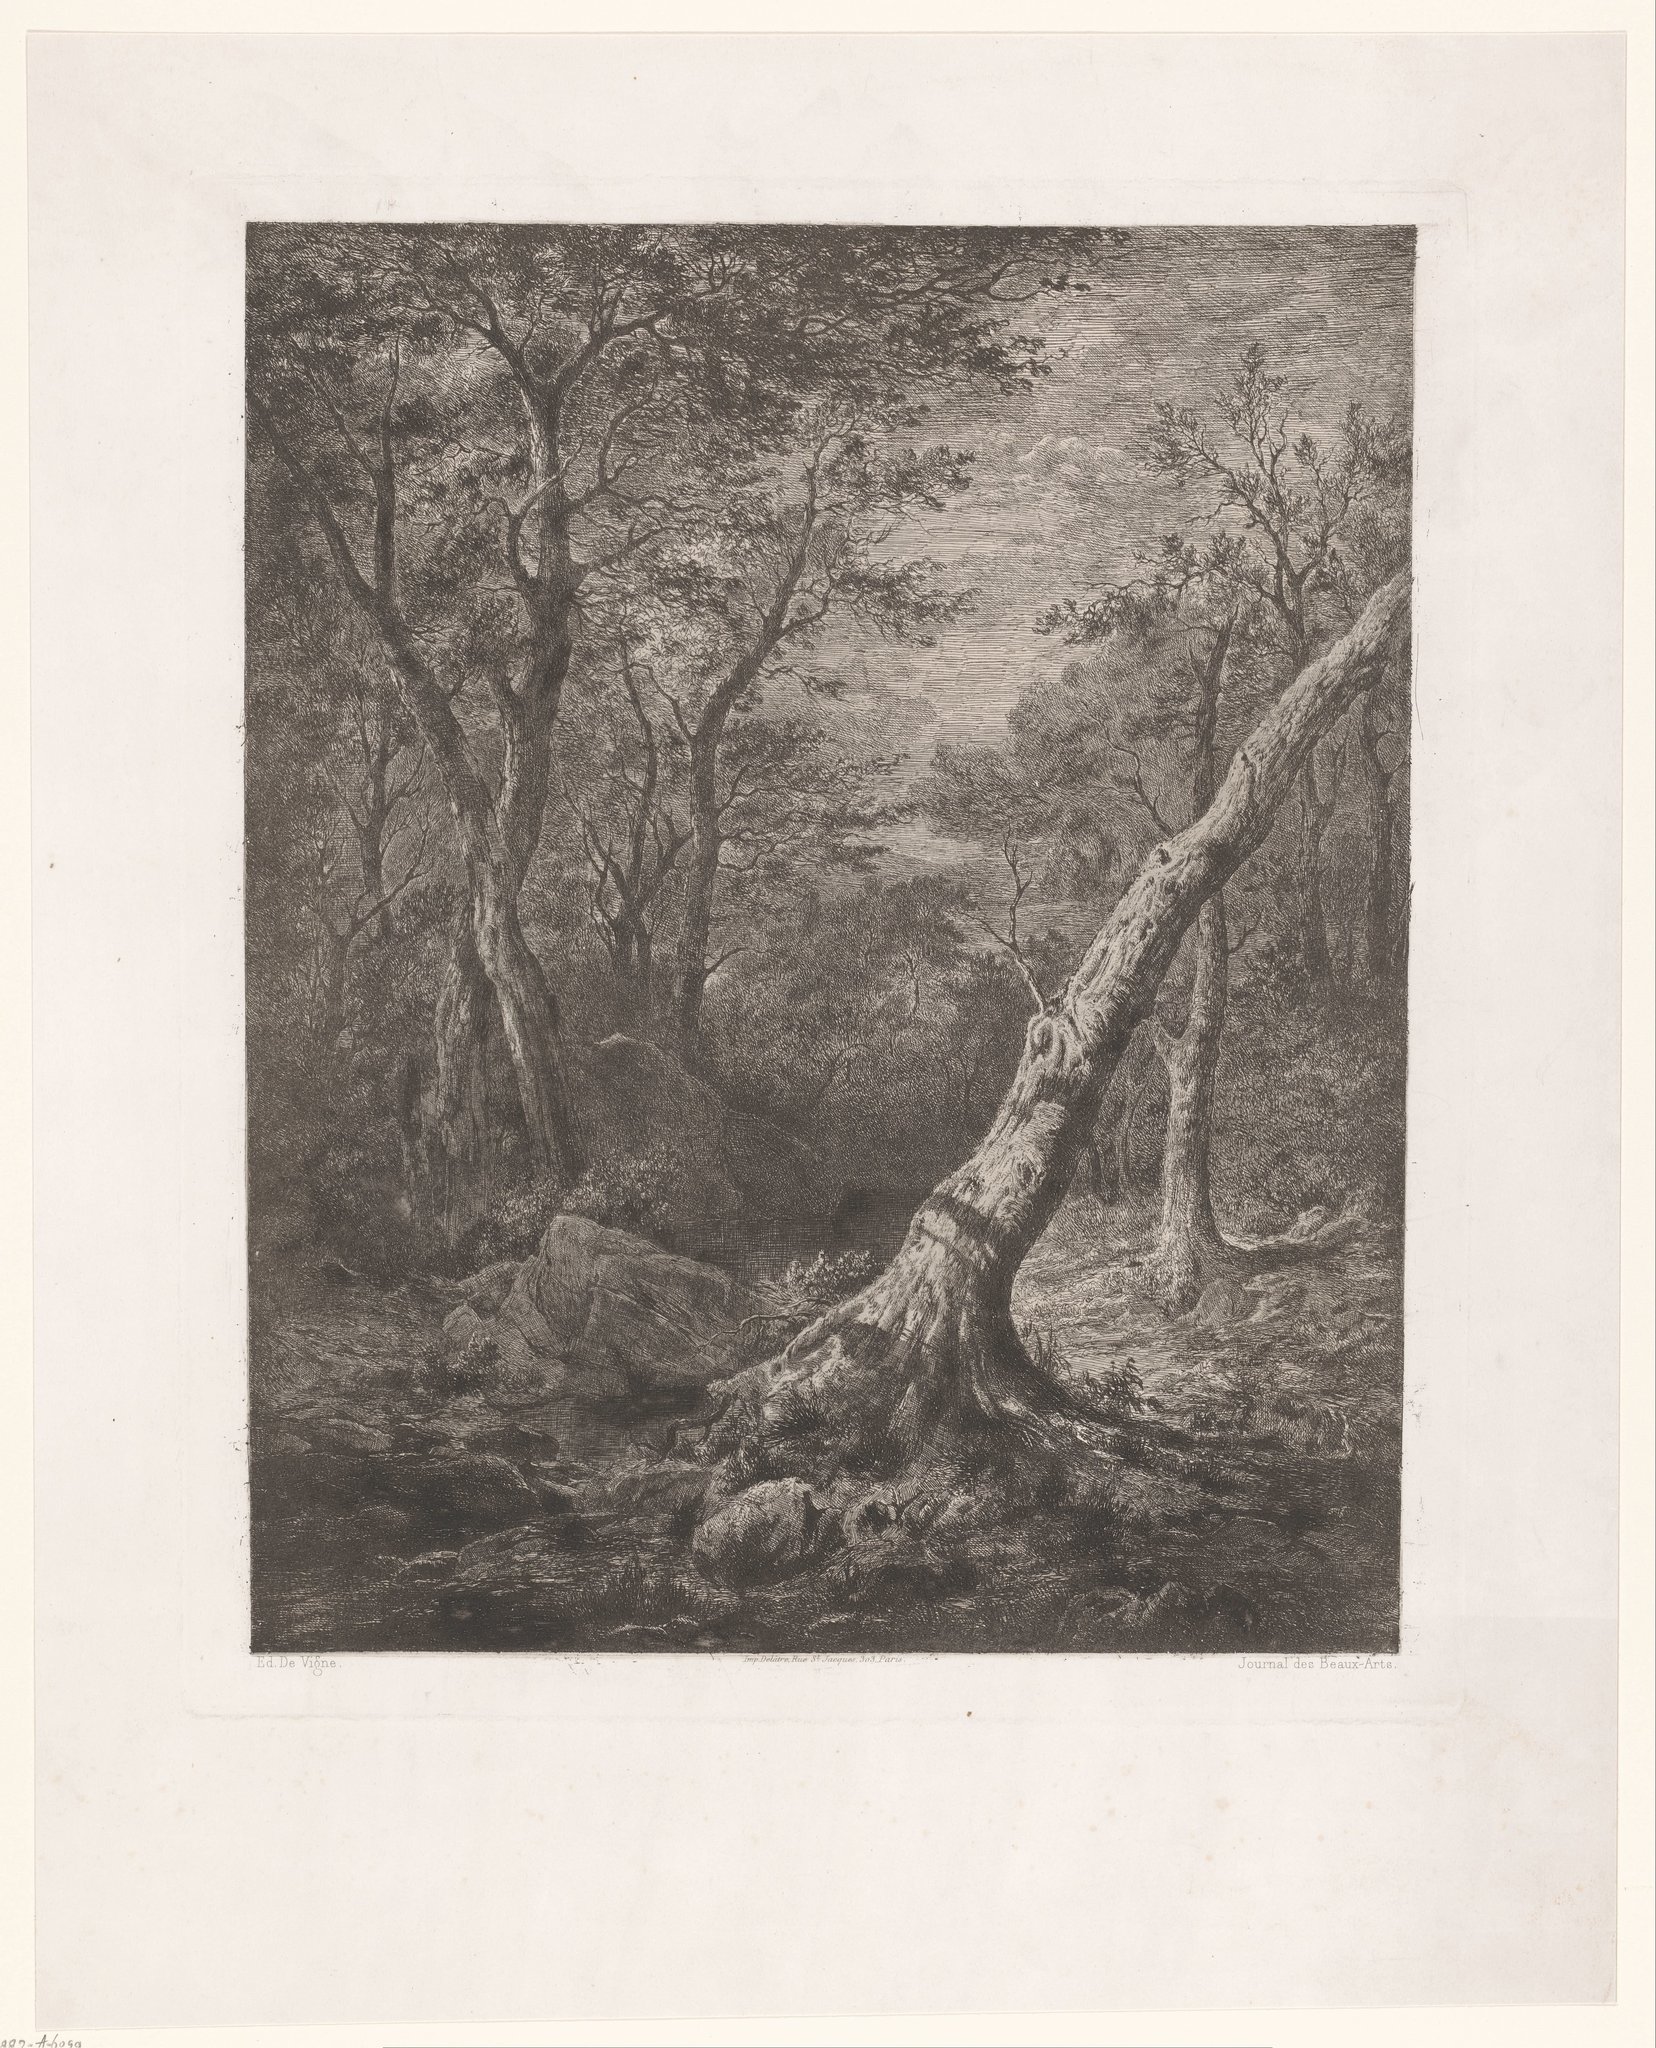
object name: print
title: Boslandschap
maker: edouard de vigne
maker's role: print maker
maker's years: 1808-1866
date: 1818-1866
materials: paper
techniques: etching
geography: belgium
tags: forest, wood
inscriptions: collector's mark: Lugt 2228